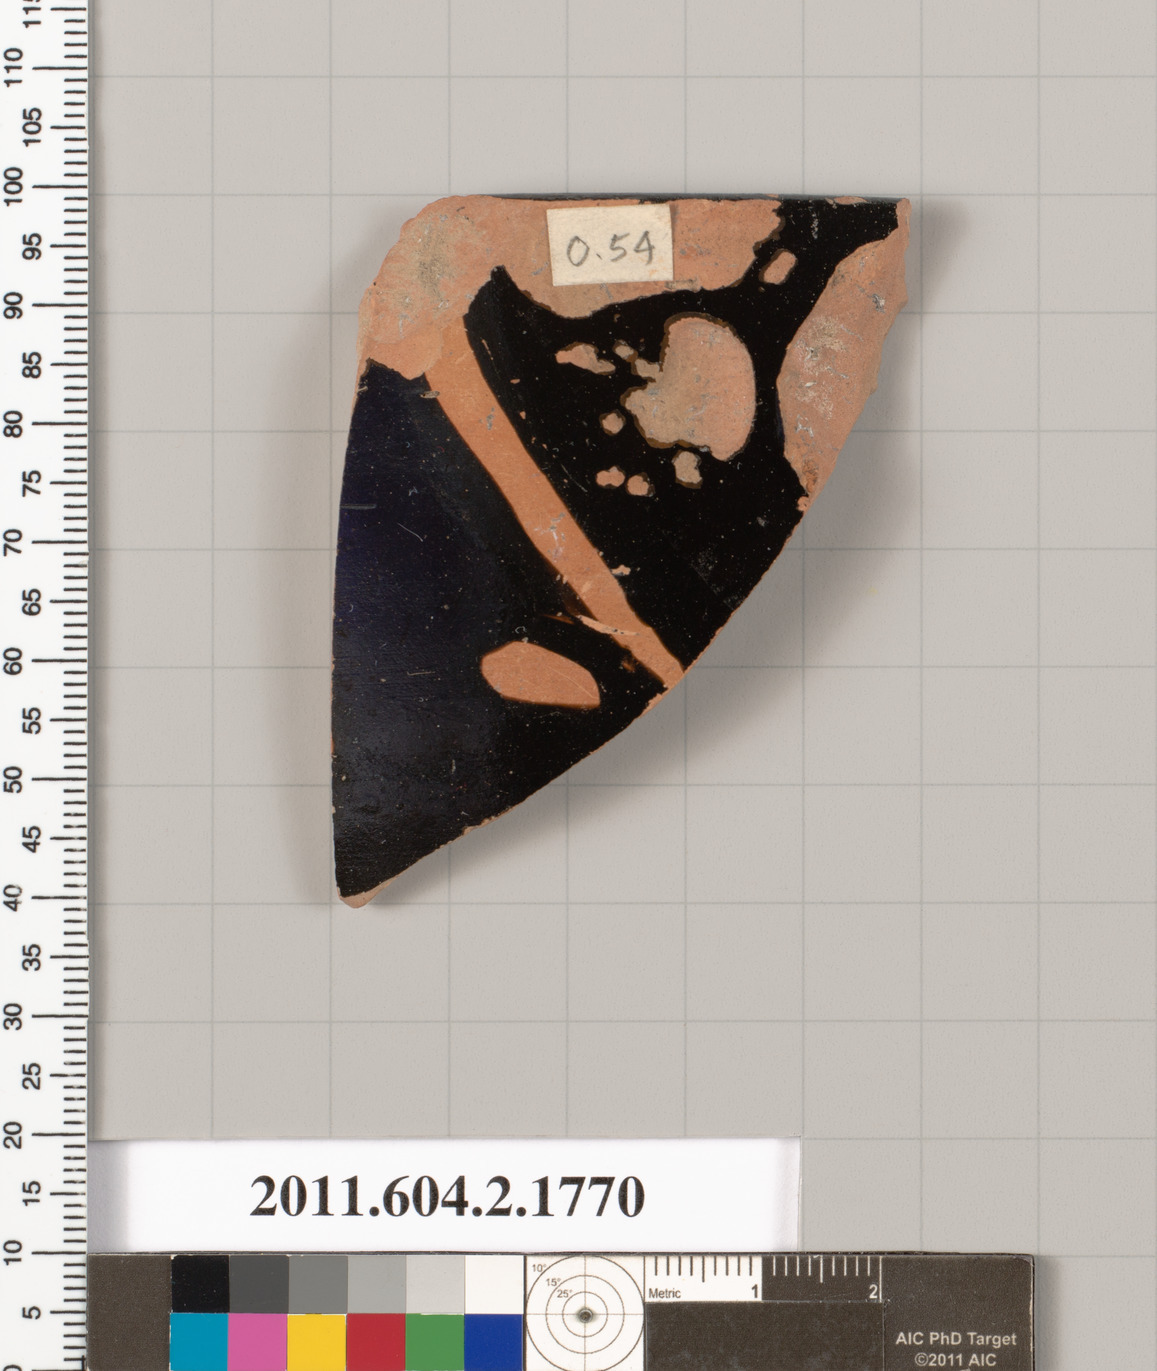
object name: skyphos fragment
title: Terracotta rim fragment of a skyphos (deep drinking cup)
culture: greek, attic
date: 434-368 BCE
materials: terracotta